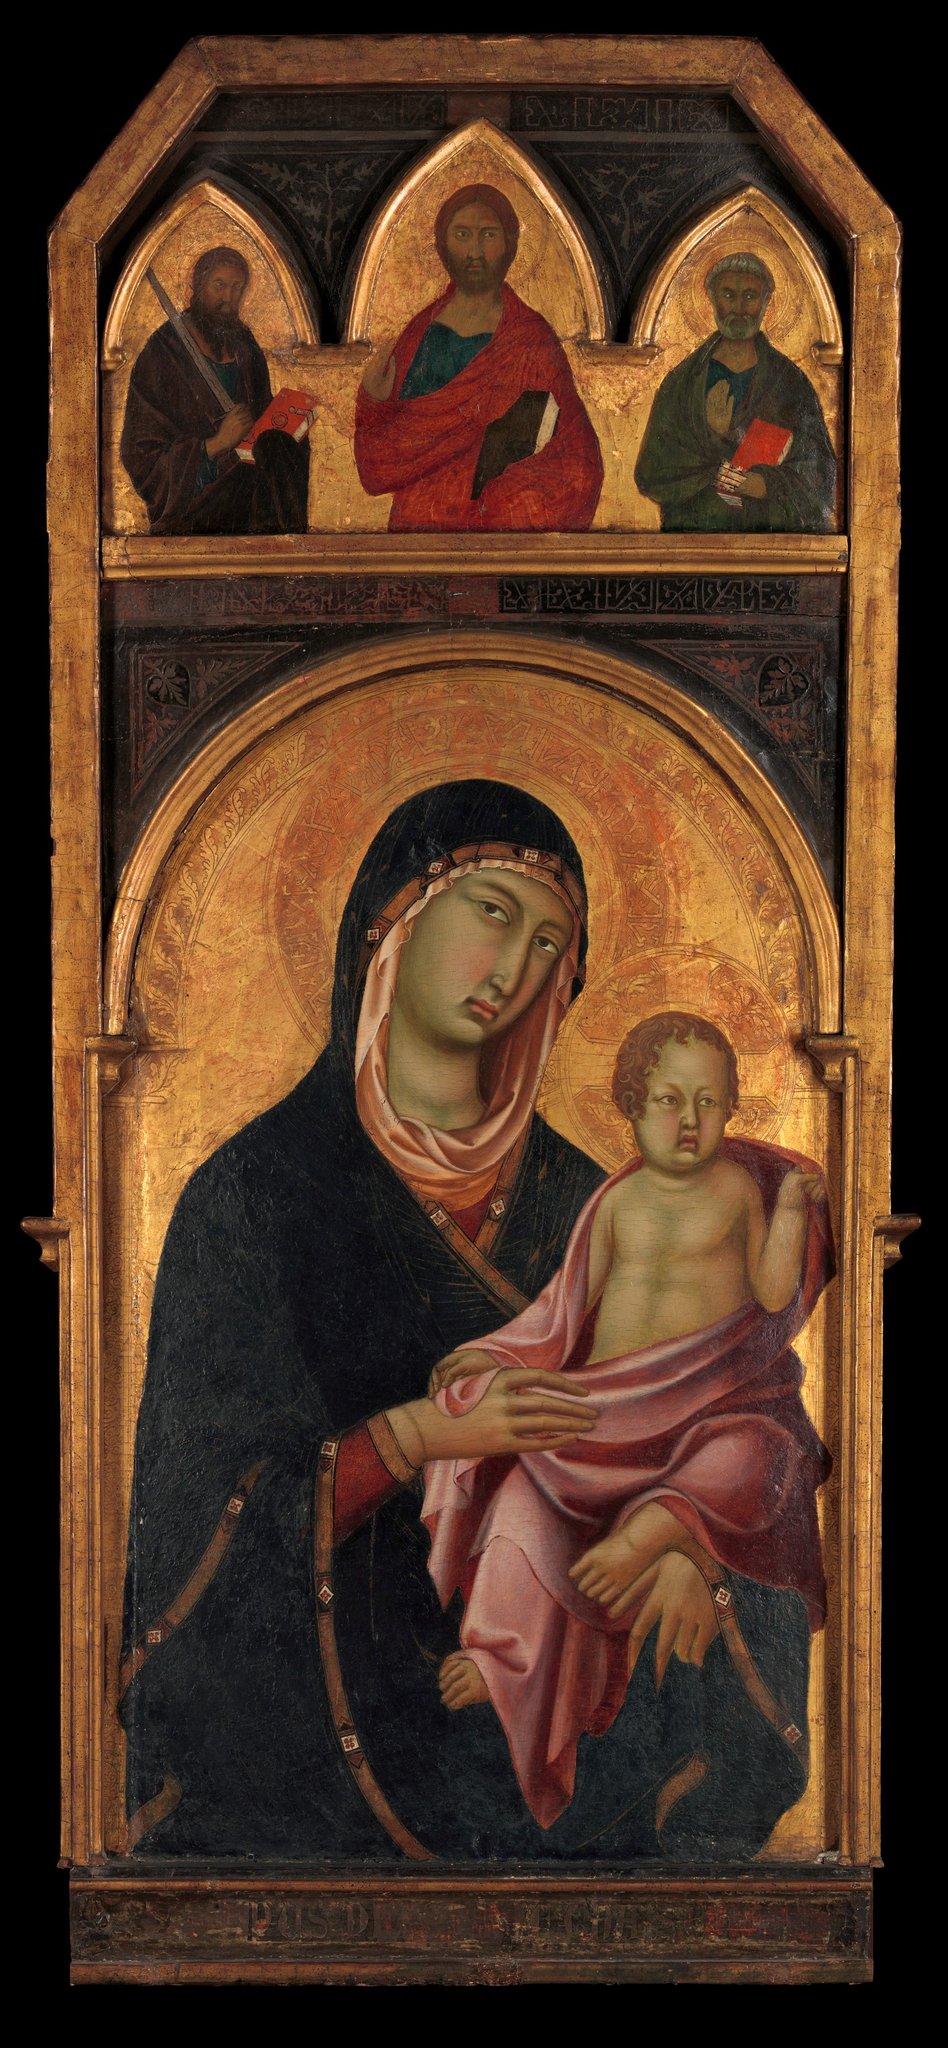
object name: painting, part of a polyptych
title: Madonna and Child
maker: segna di buonaventura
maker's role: artist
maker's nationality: italian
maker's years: 1298-1331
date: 1320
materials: gold leaf, paint, wood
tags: christ,madonna and child,saint paul,saint peter,virgin mary